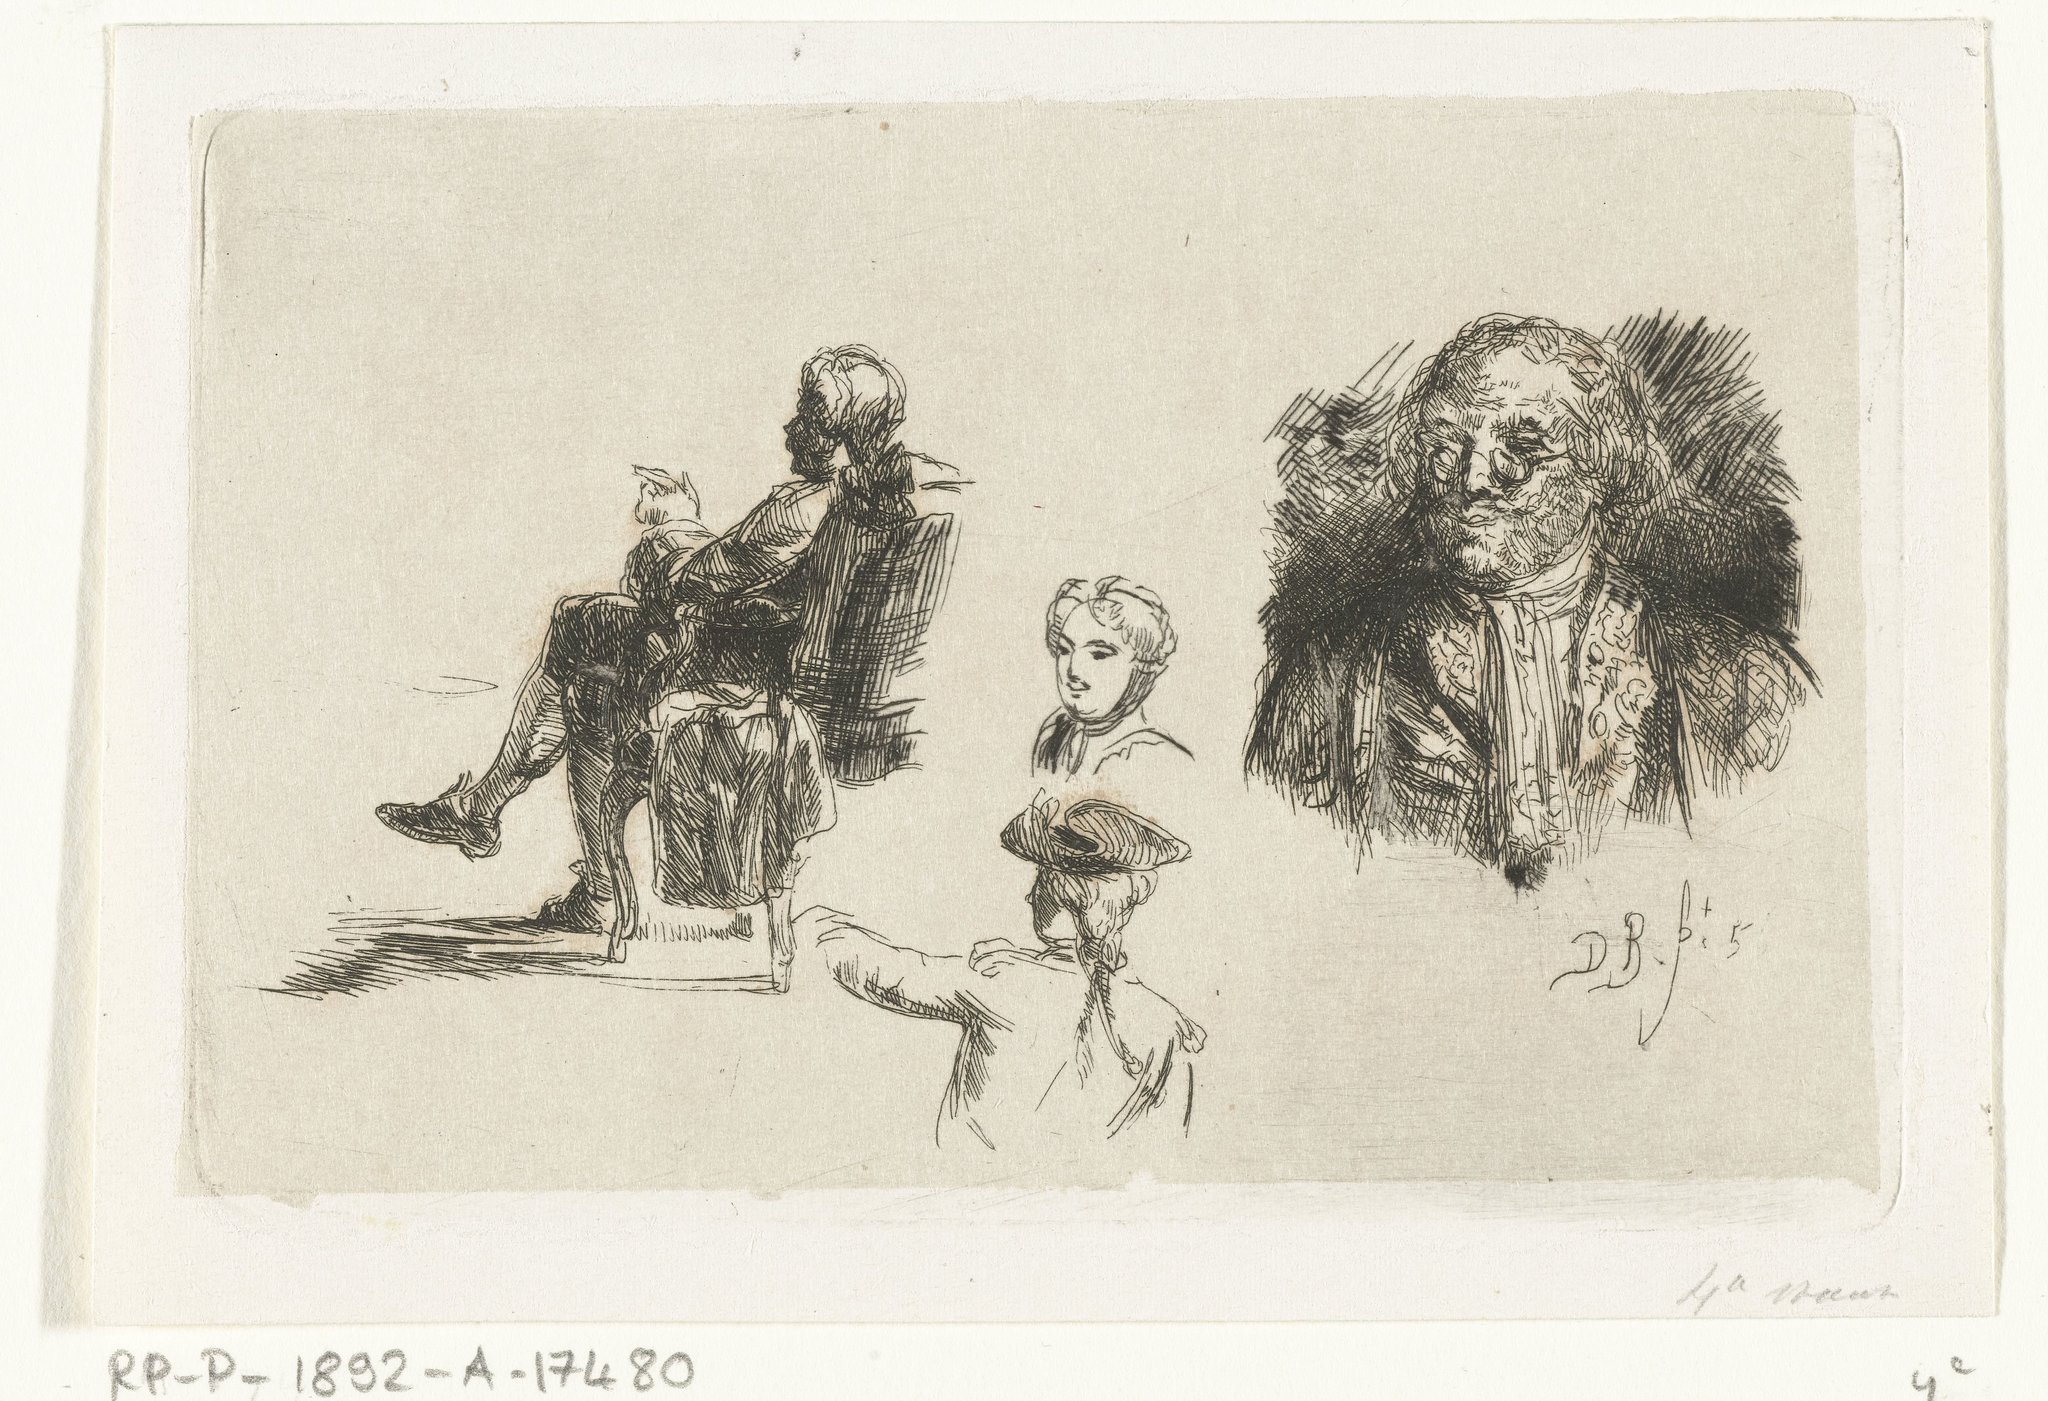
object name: print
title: Studieblad met vier figuren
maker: david bles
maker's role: draughtsman, painter, print maker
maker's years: 1821-1899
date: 1856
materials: paper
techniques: etching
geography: the hague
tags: drawing, sketch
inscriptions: collector's mark: Lugt 2228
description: Links zit een man in een leunstoel, onder een soldaat met een hoed op, rechts een borstbeeld van een oudere heer met bril, in het midden de buste van een vrouw met opgestoken haar.